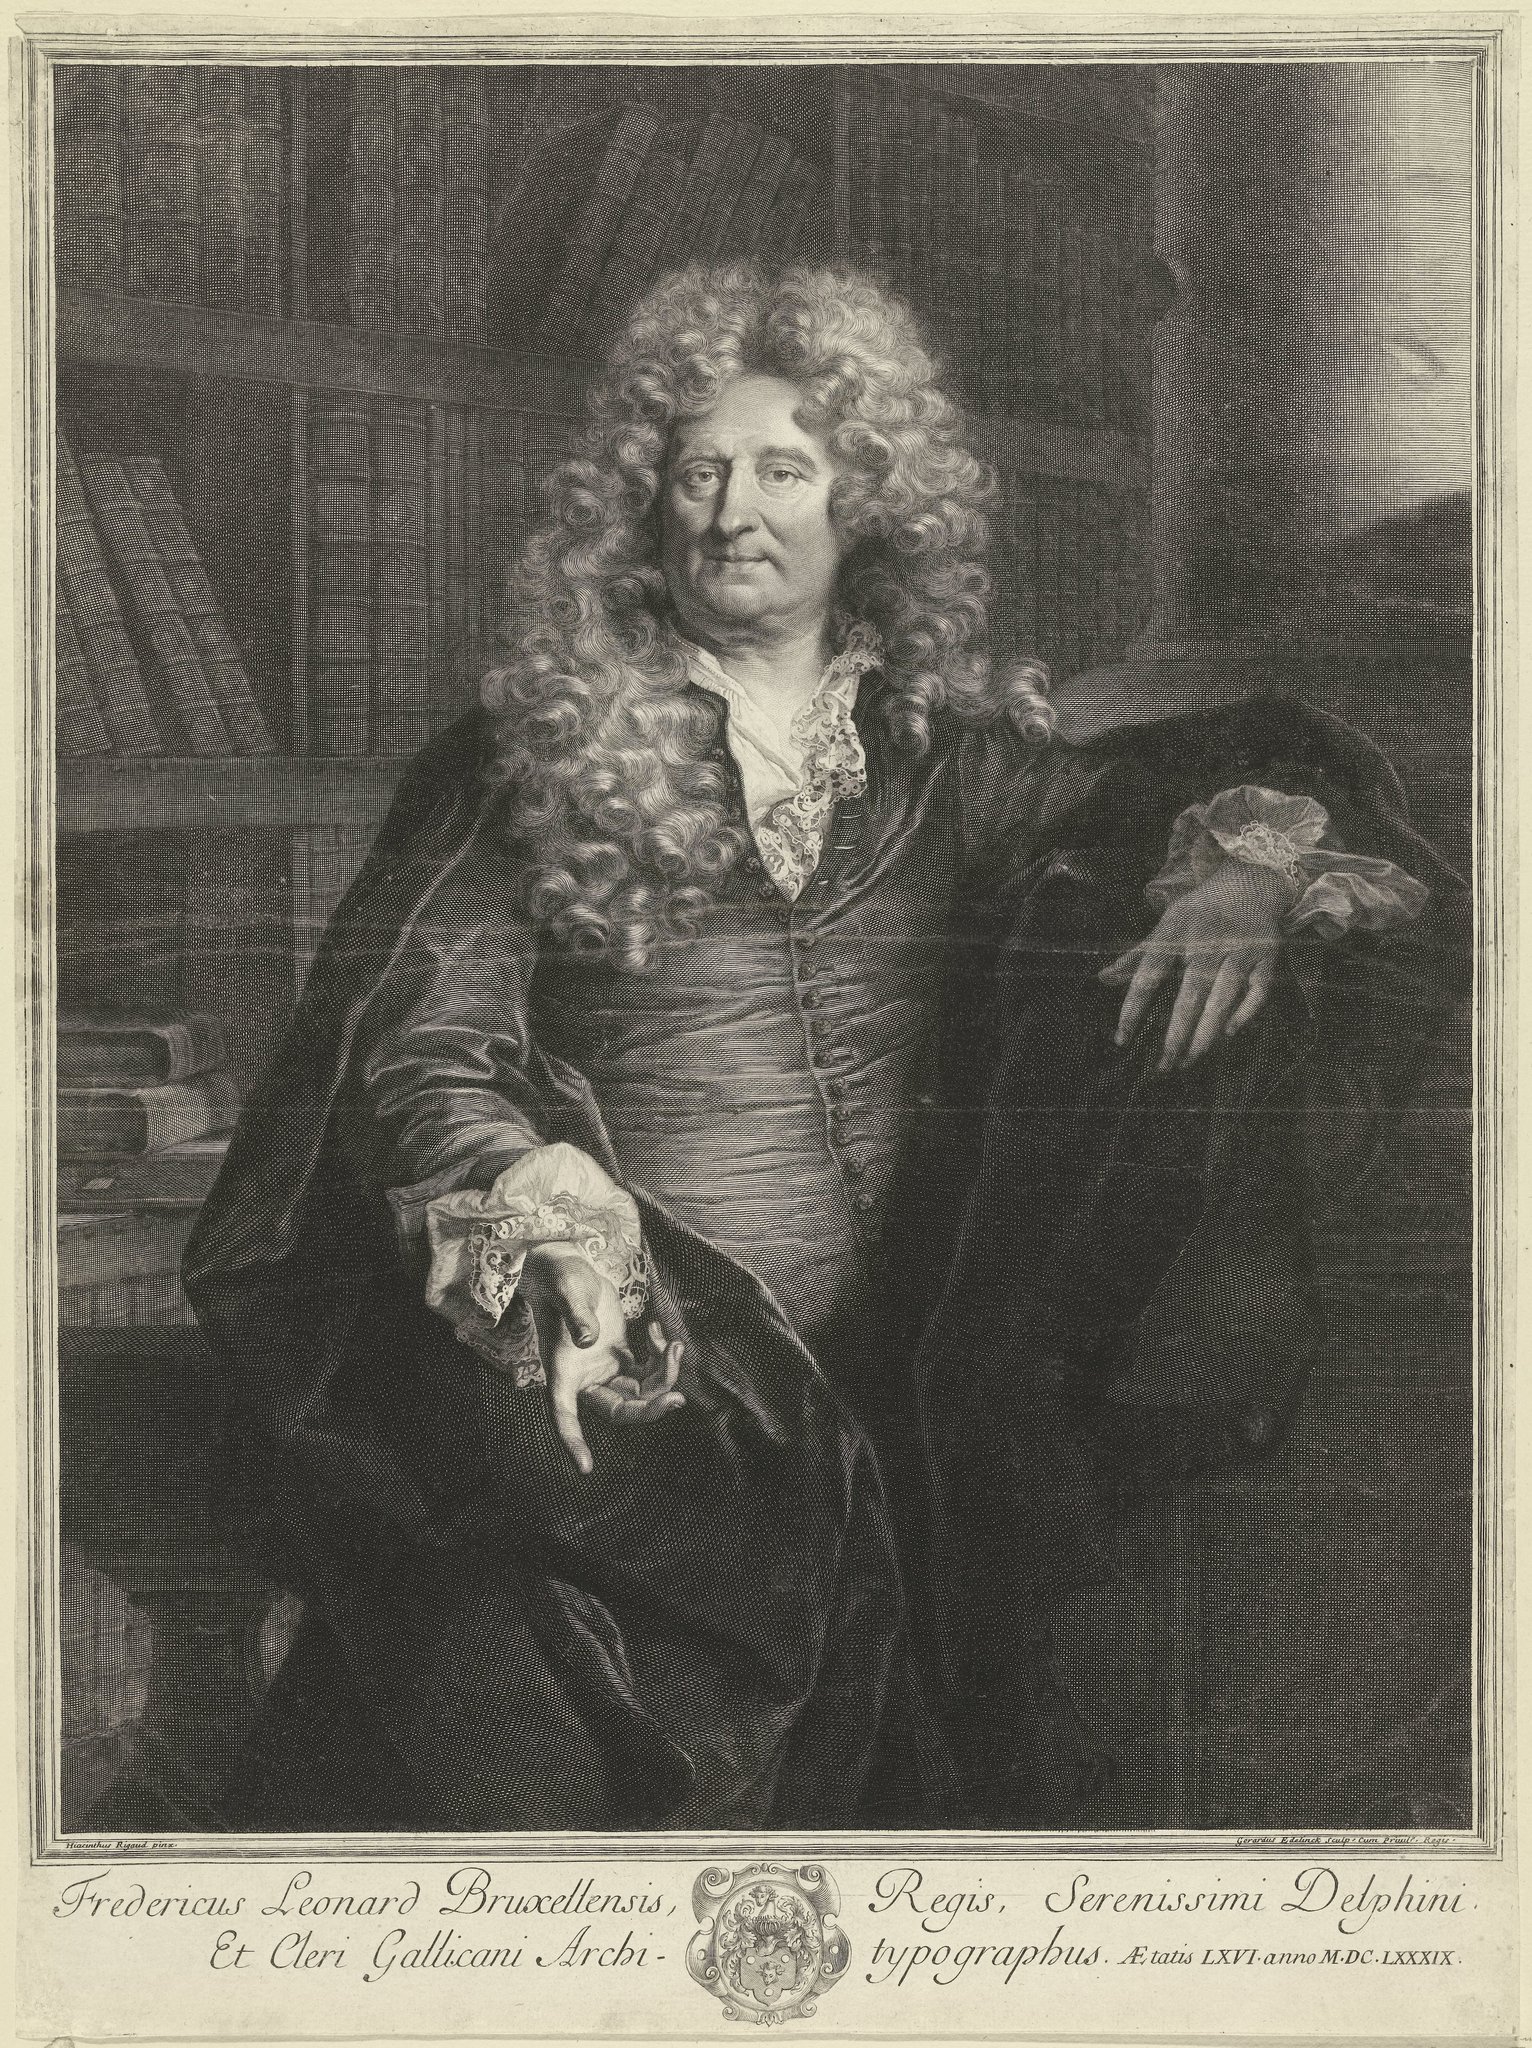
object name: print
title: Portret van Frédéric Leonard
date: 1689-1707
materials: paper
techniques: engraving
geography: france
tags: brussels, frédéric léonard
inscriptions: collector's mark: Lugt 240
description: Portret van de Franse drukker Frédéric Leonard (1623-1712), ten halven lijve afgebeeld in bibliotheek. Onder het portret een wapen met aan weerszijden twee regels Latijn.